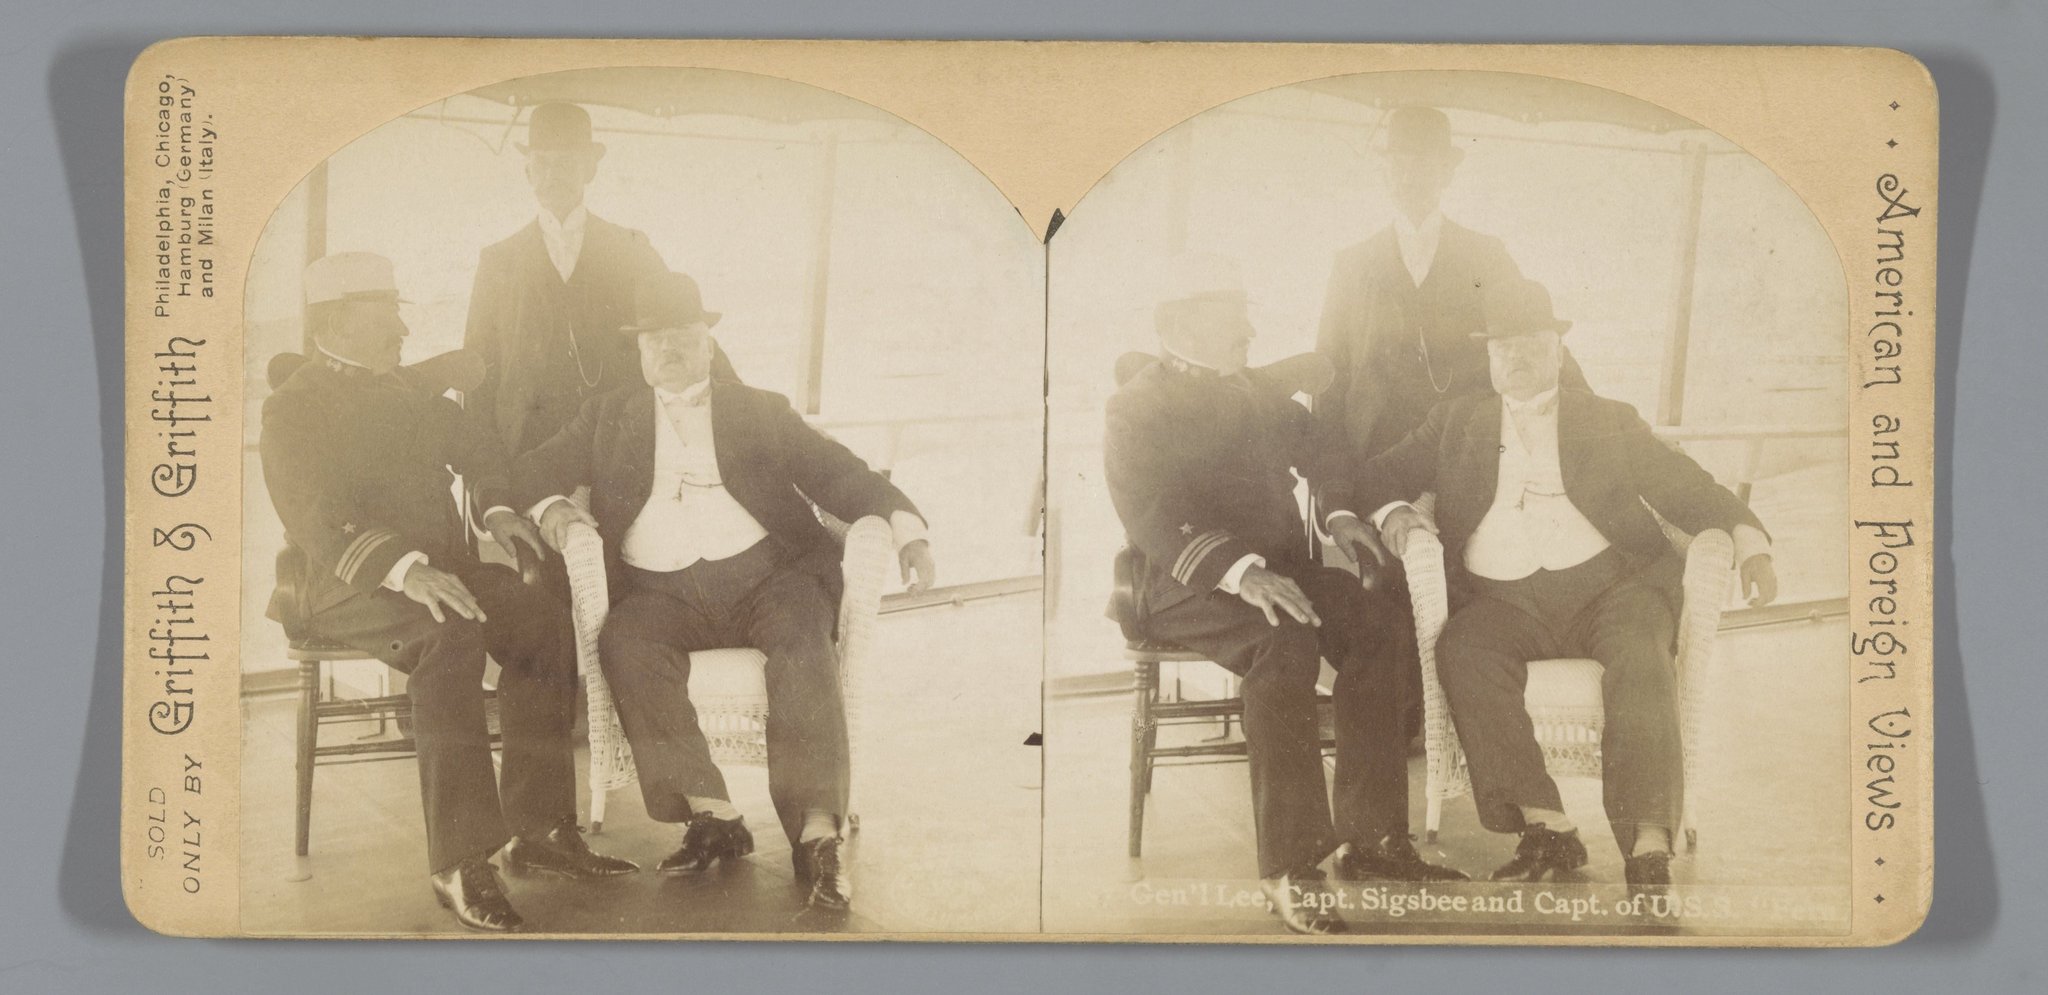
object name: stereograph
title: American and Foreign Views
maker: william herman rau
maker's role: publisher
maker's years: 1855-1920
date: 1898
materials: cardboard, paper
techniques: albumen print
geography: key west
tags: new york (city), naval officer, historical persons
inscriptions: number: ‘36’, number: ‘57 [onz]’